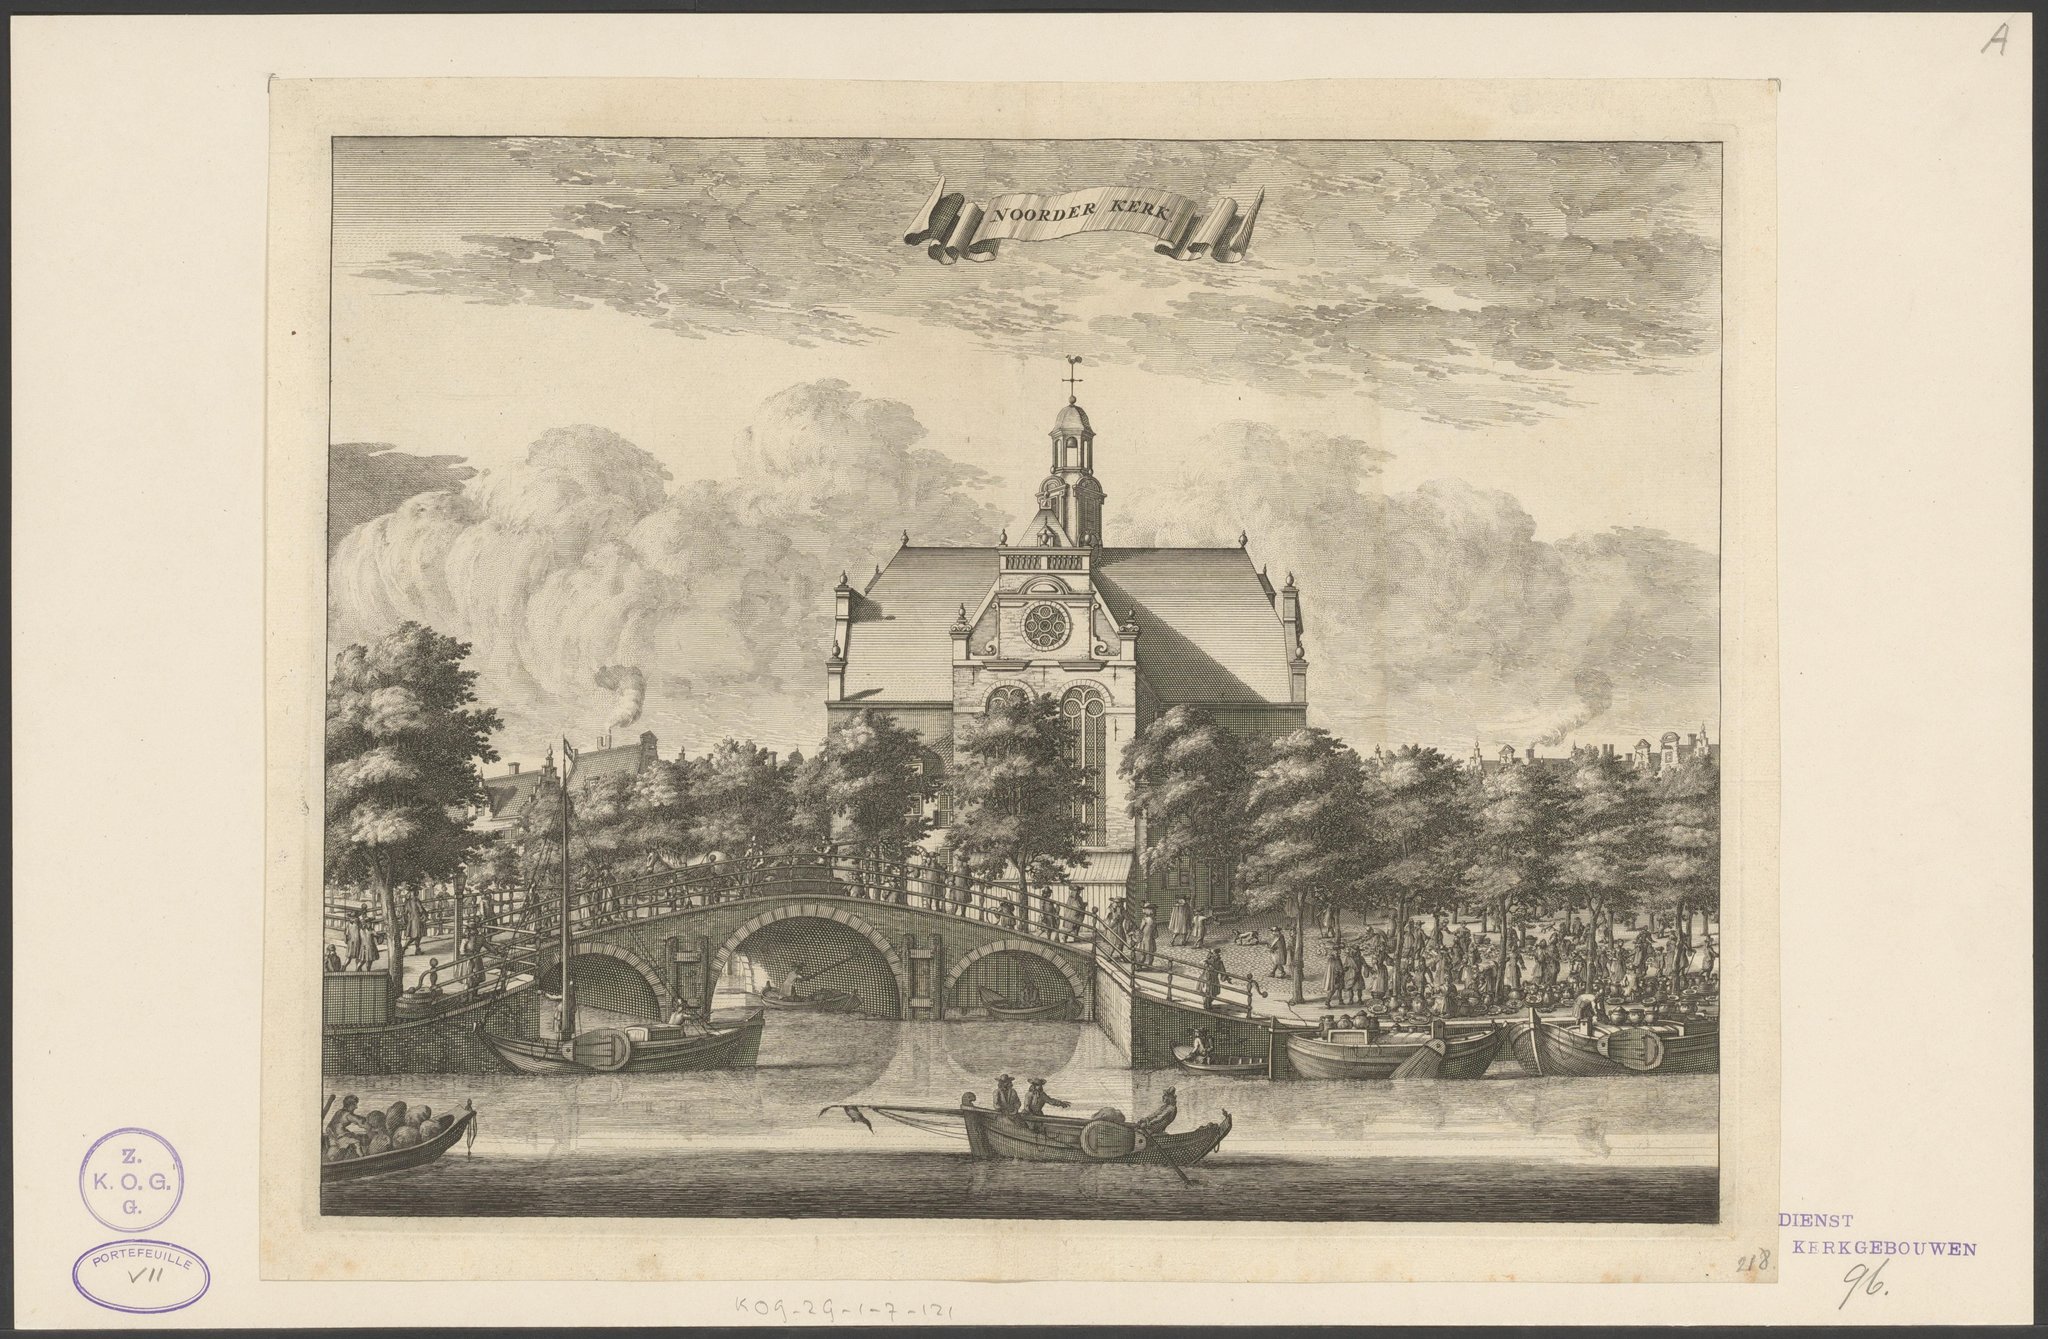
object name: print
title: Gezicht op de Noorderkerk te Amsterdam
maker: Anonymous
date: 1693-1694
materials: paper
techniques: etching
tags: church (exterior), bridge, street (+ city(-scape) with figures, staffage)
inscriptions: stamp, stamp, collector's mark: Lugt 1641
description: Prent uit: Commelin, Caspar. Beschryvinge van Amsterdam, zynde een naukeurige verhandelinge van desselfs eerste oorspronk uyt (…). Amsterdam: Andries van Damme et al., 1726. Eerdere staat van prent werd gebruikt in: Commelin, Caspar. Beschryvinge van Amsterdam, desselfs eerste oorspronk uyt den Huyse (…). Amsterdam: Abraham Wolfgang et al., 1693. En in: Commelin, Caspar. Beschryvinge van Amsterdam, zynde een naukeurige verhandelinge van desselfs eerste oorspronk uyt (…). Amsterdam: weduwe Aart Dircksz Oossaan, 1694.